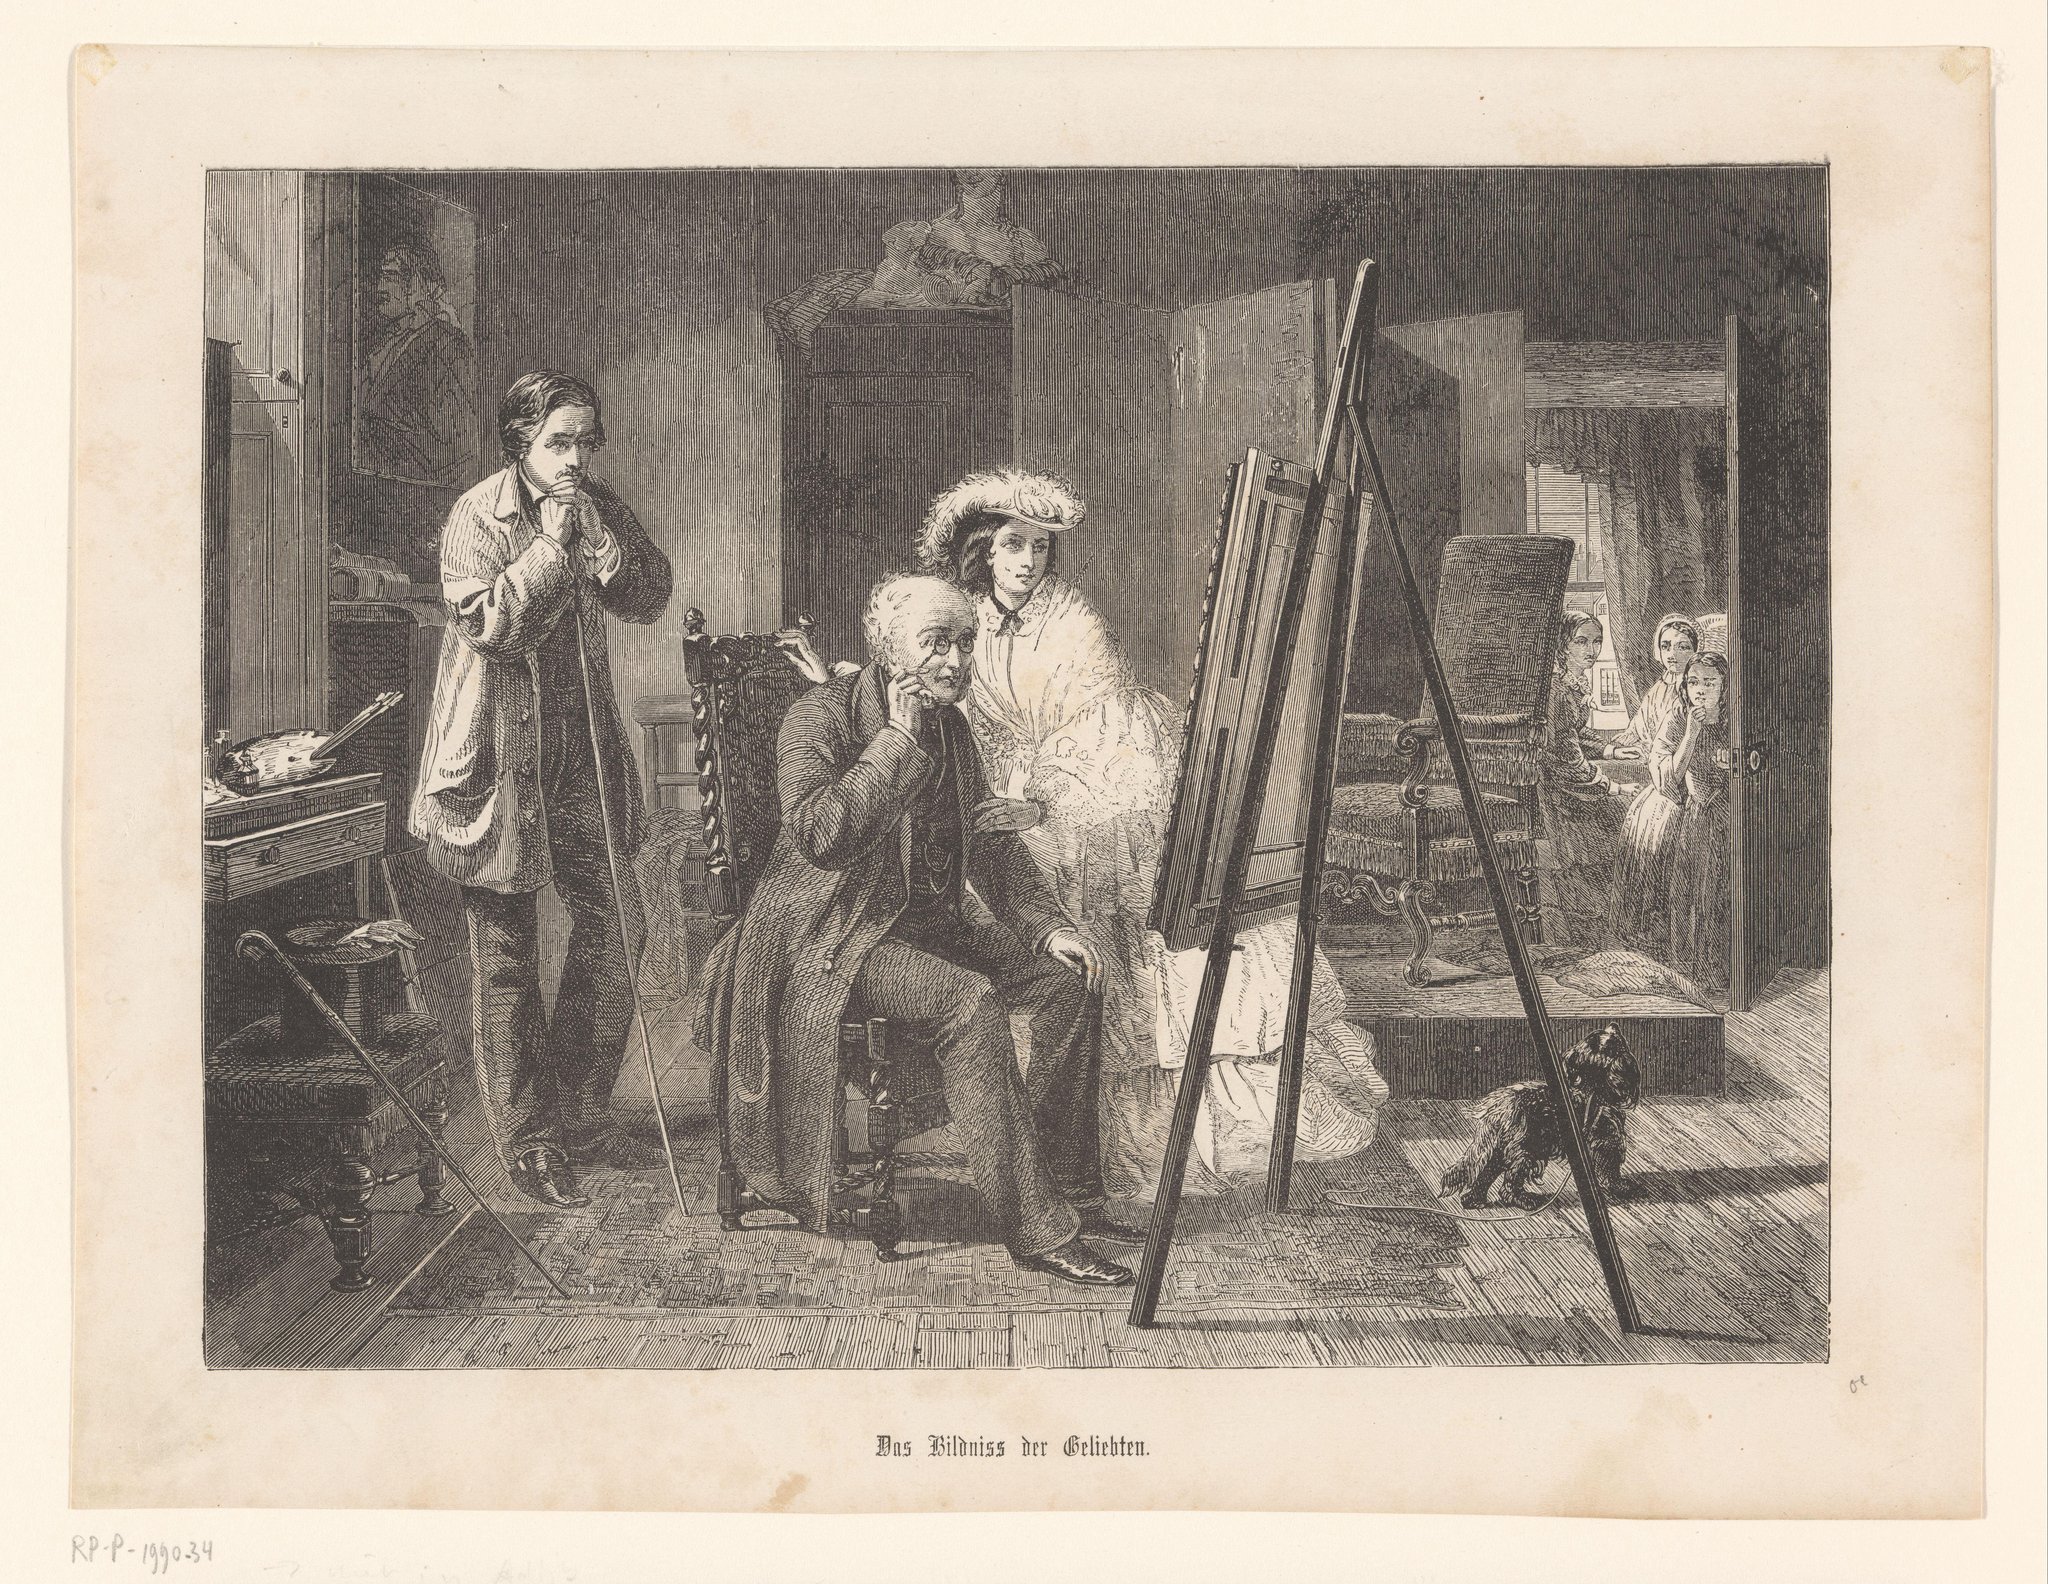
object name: print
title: Studiobezoek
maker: Anonymous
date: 1818-1899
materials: paper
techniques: lithograph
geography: germany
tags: painter at work, in his studio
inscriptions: collector's mark: Lugt 2228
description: Man en vrouw bekijken een kunstwerk in het atelier van een kunstenaar.